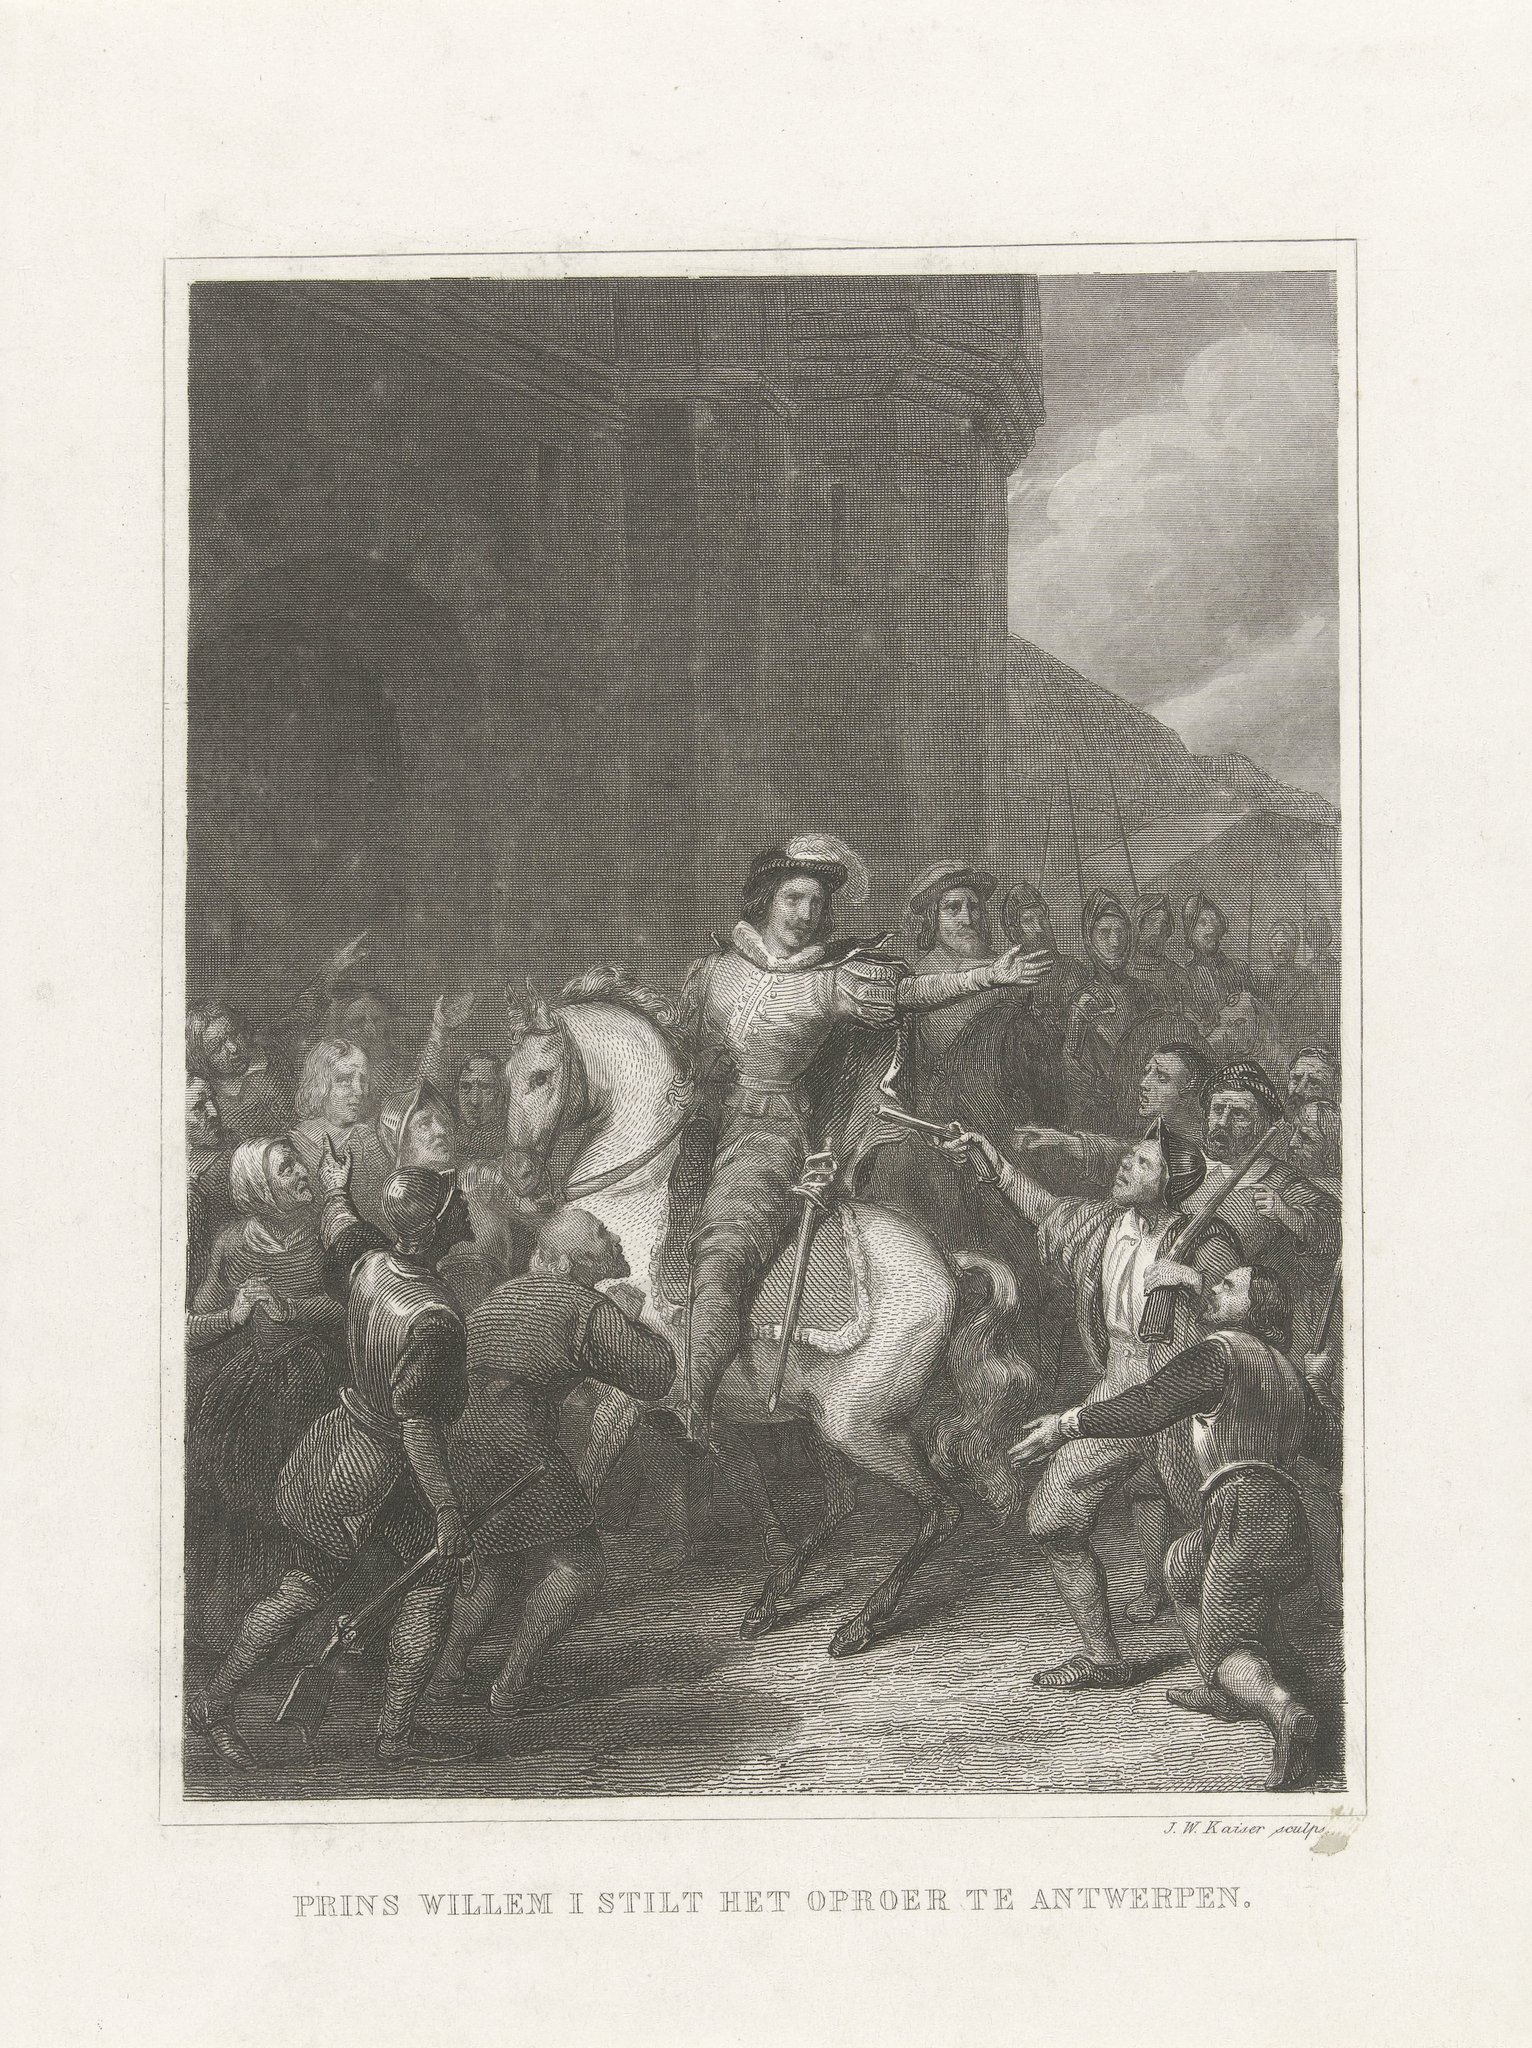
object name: print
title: Prins Willem I stilt het oproer te Antwerpen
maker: johann wilhelm kaiser (i)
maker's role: draughtsman, print maker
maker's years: 1813-1900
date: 1847-1849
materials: paper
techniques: engraving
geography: netherlands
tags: delft, william i (prince of orange), antwerp, mayor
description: Willem van Oranje, burgemeester Anton van Straelen en Hoogstraten stillen calvinistisch oproer in Antwerpen, 14 maart 1567.